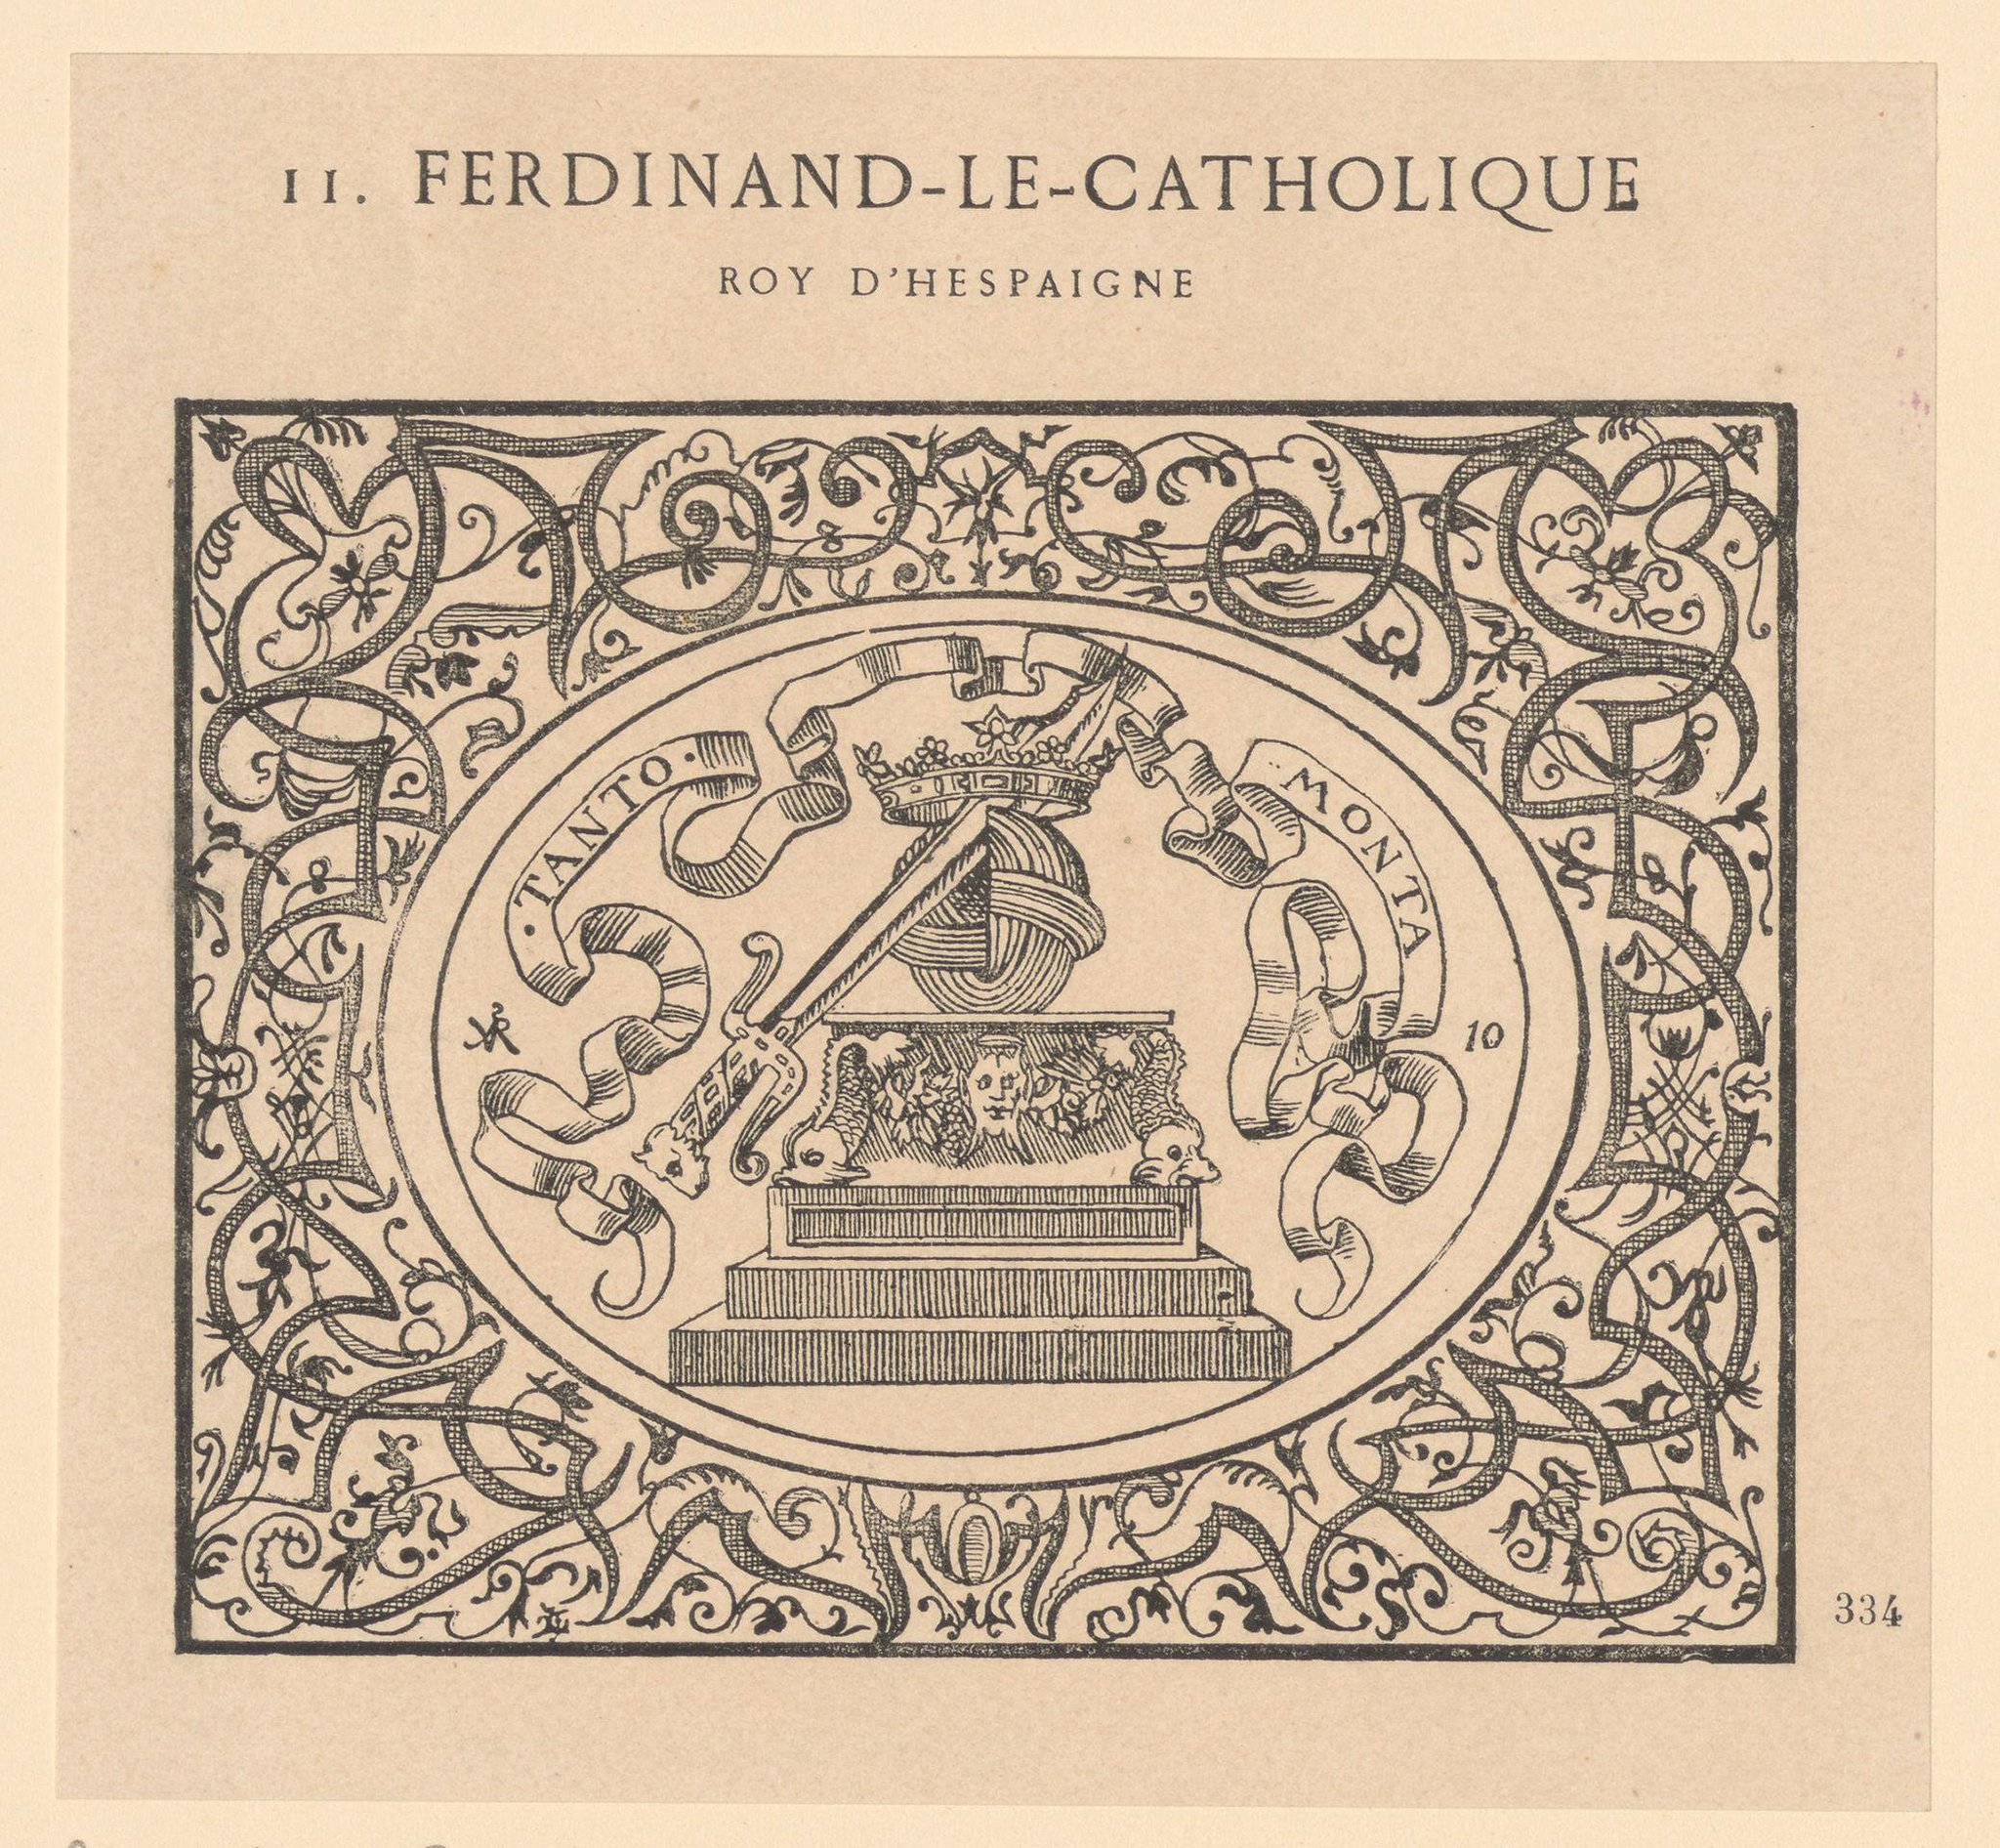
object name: photomechanical print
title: Motto 'Tanto Monta' van Ferdinand II van Aragon en Isabella I van Castilië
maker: Anonymous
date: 1850-1900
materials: paper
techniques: line block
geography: france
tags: historical persons, armorial bearing, heraldry (...) - device, motto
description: Linksboven genummerd: 11. Rechtsonder genummerd: 334.